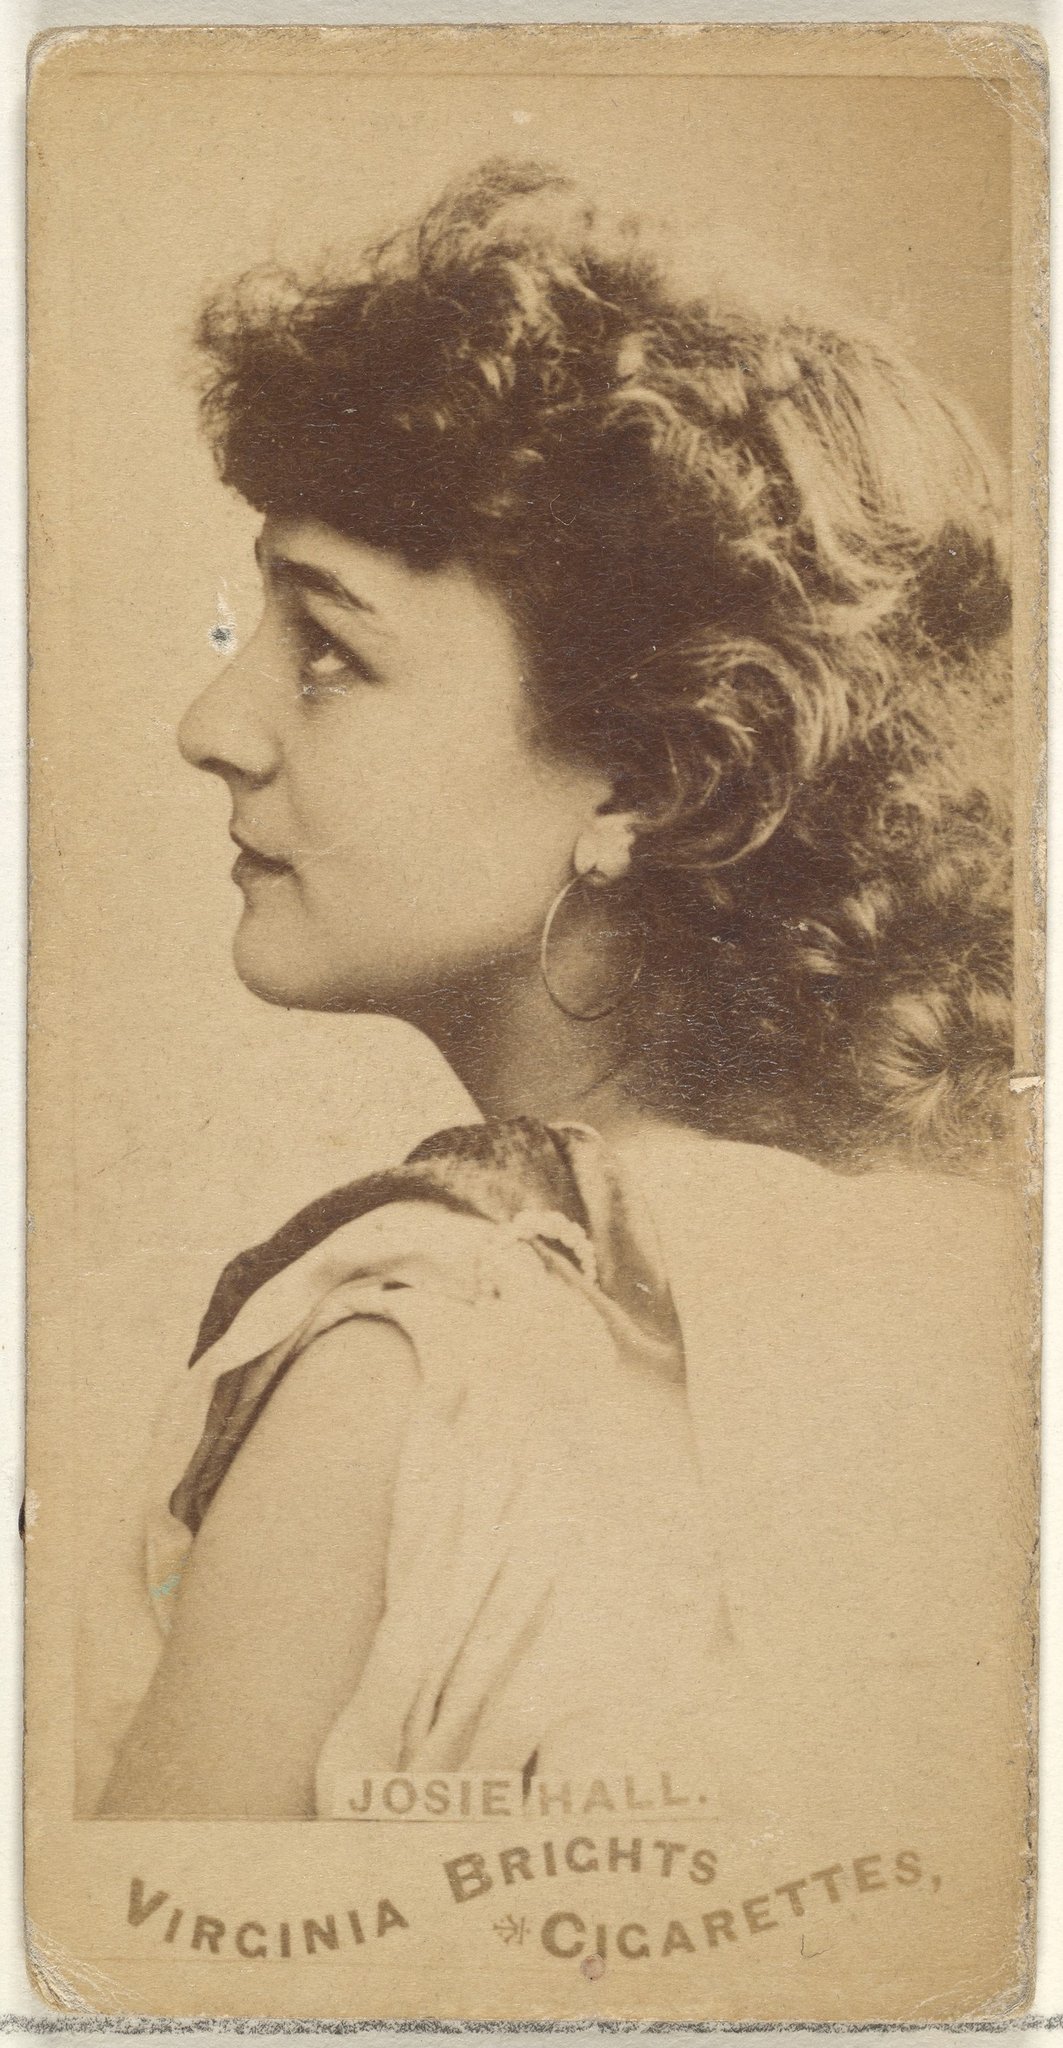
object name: photograph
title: Josie Hall, from the Actors and Actresses series (N45, Type 1) for Virginia Brights Cigarettes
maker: allen & ginter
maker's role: publisher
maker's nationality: american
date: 1888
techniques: albumen silver print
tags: profiles,women,actresses